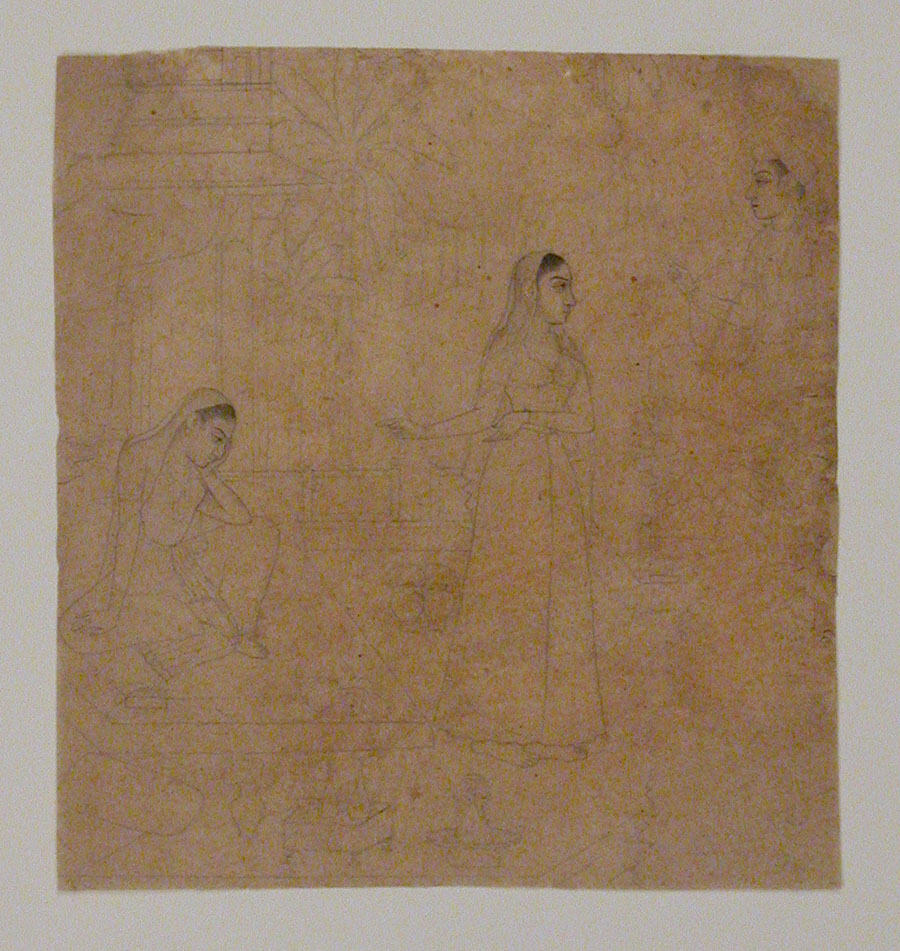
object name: illustrated single work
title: Love Scene from the Rasikapriya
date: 1701-1800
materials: ink, paper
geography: india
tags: men,women